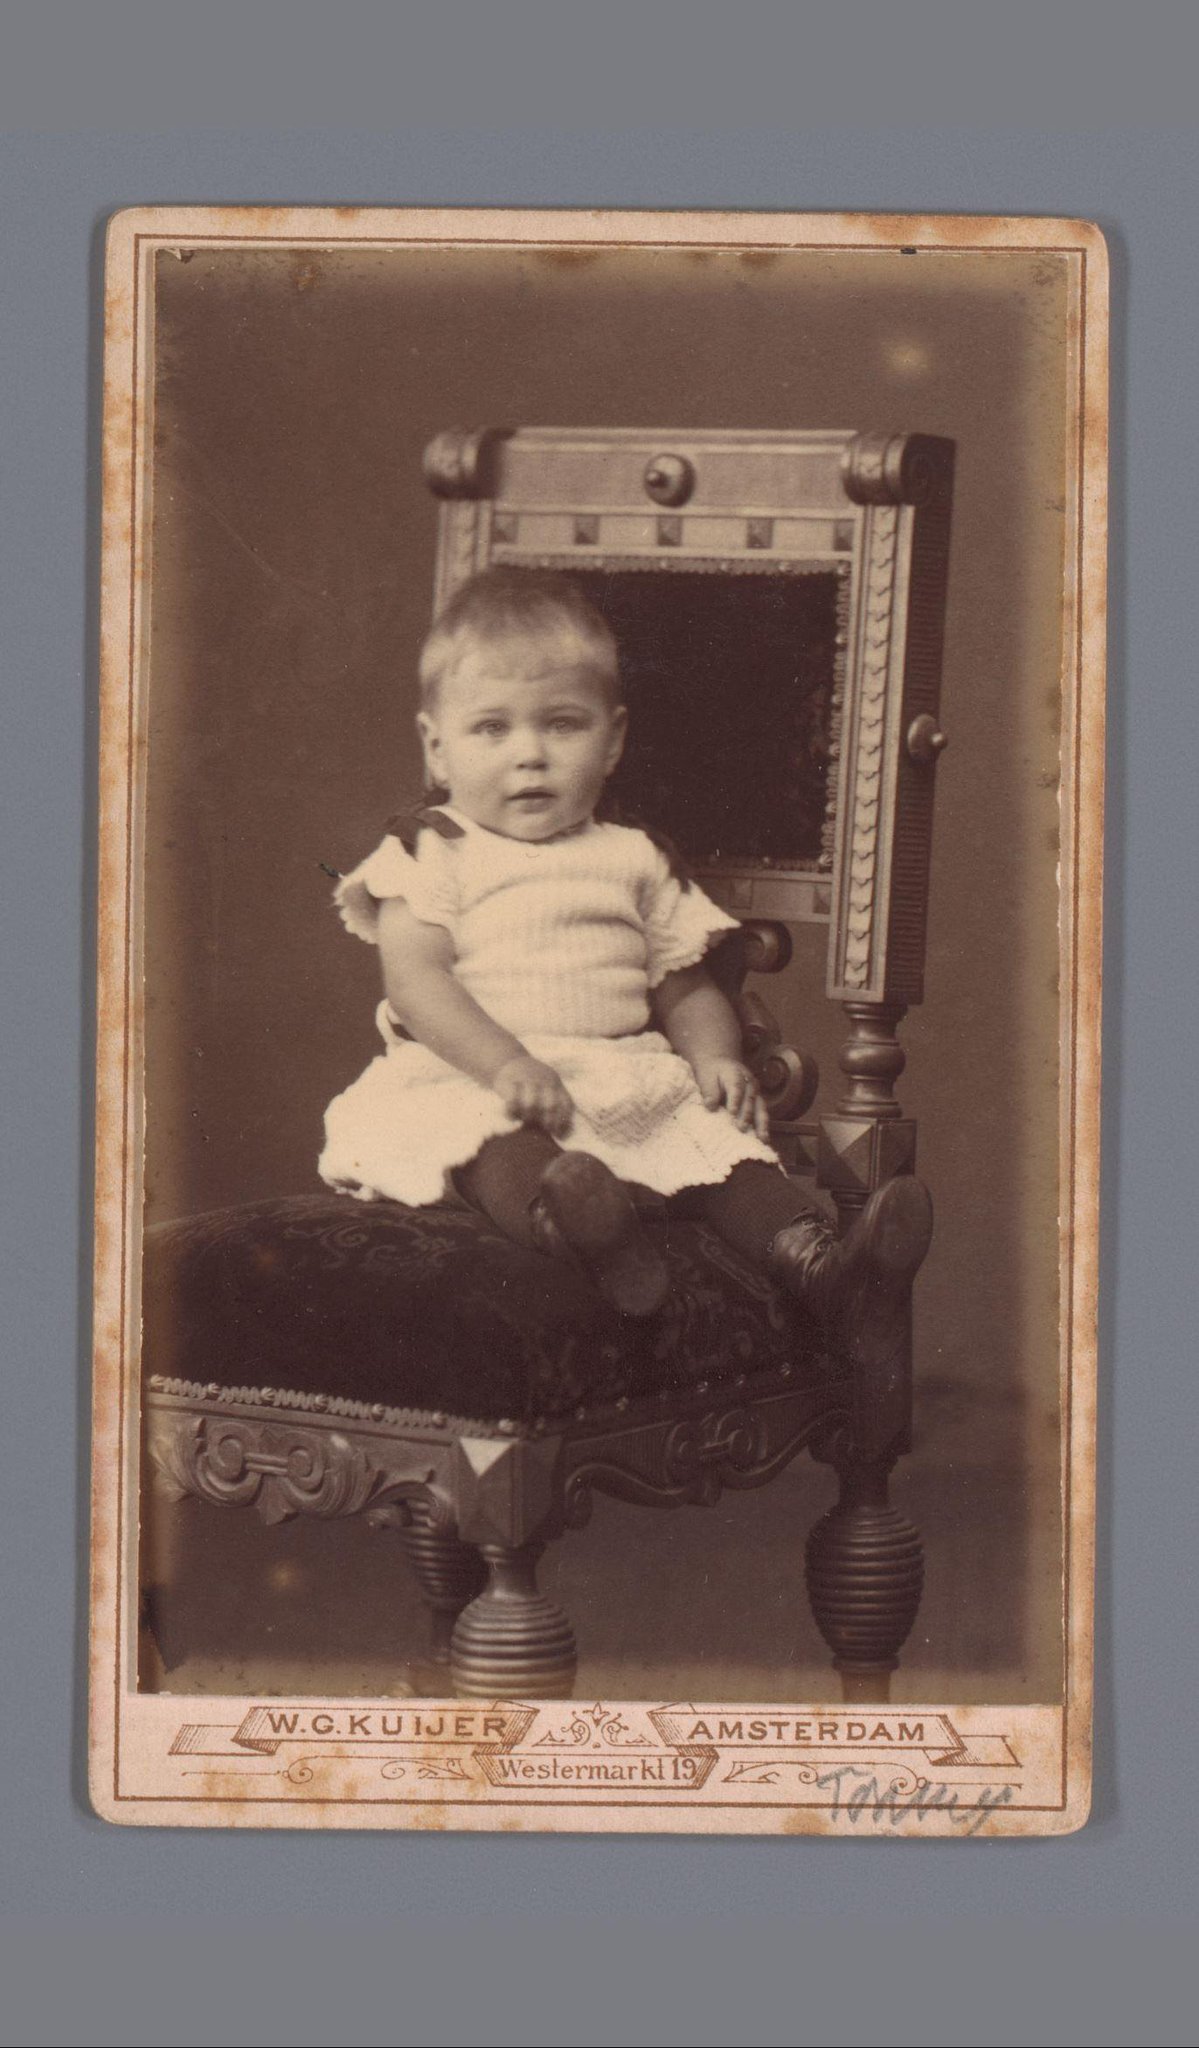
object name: carte de visite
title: Portret van A.J. Langhout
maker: willem gerhardus kuijer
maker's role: fotograaf, hoffotograaf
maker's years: 1834-1899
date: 1885-1906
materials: cardboard, photographic support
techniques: collodion silver print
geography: amsterdam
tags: historical persons, amsterdam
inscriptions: annotation: ‘Tommy’, annotation: ‘Tommy’, workshop stamp: ‘Amsterdam/ W.G. Kuijer/ Westermarkt 19’